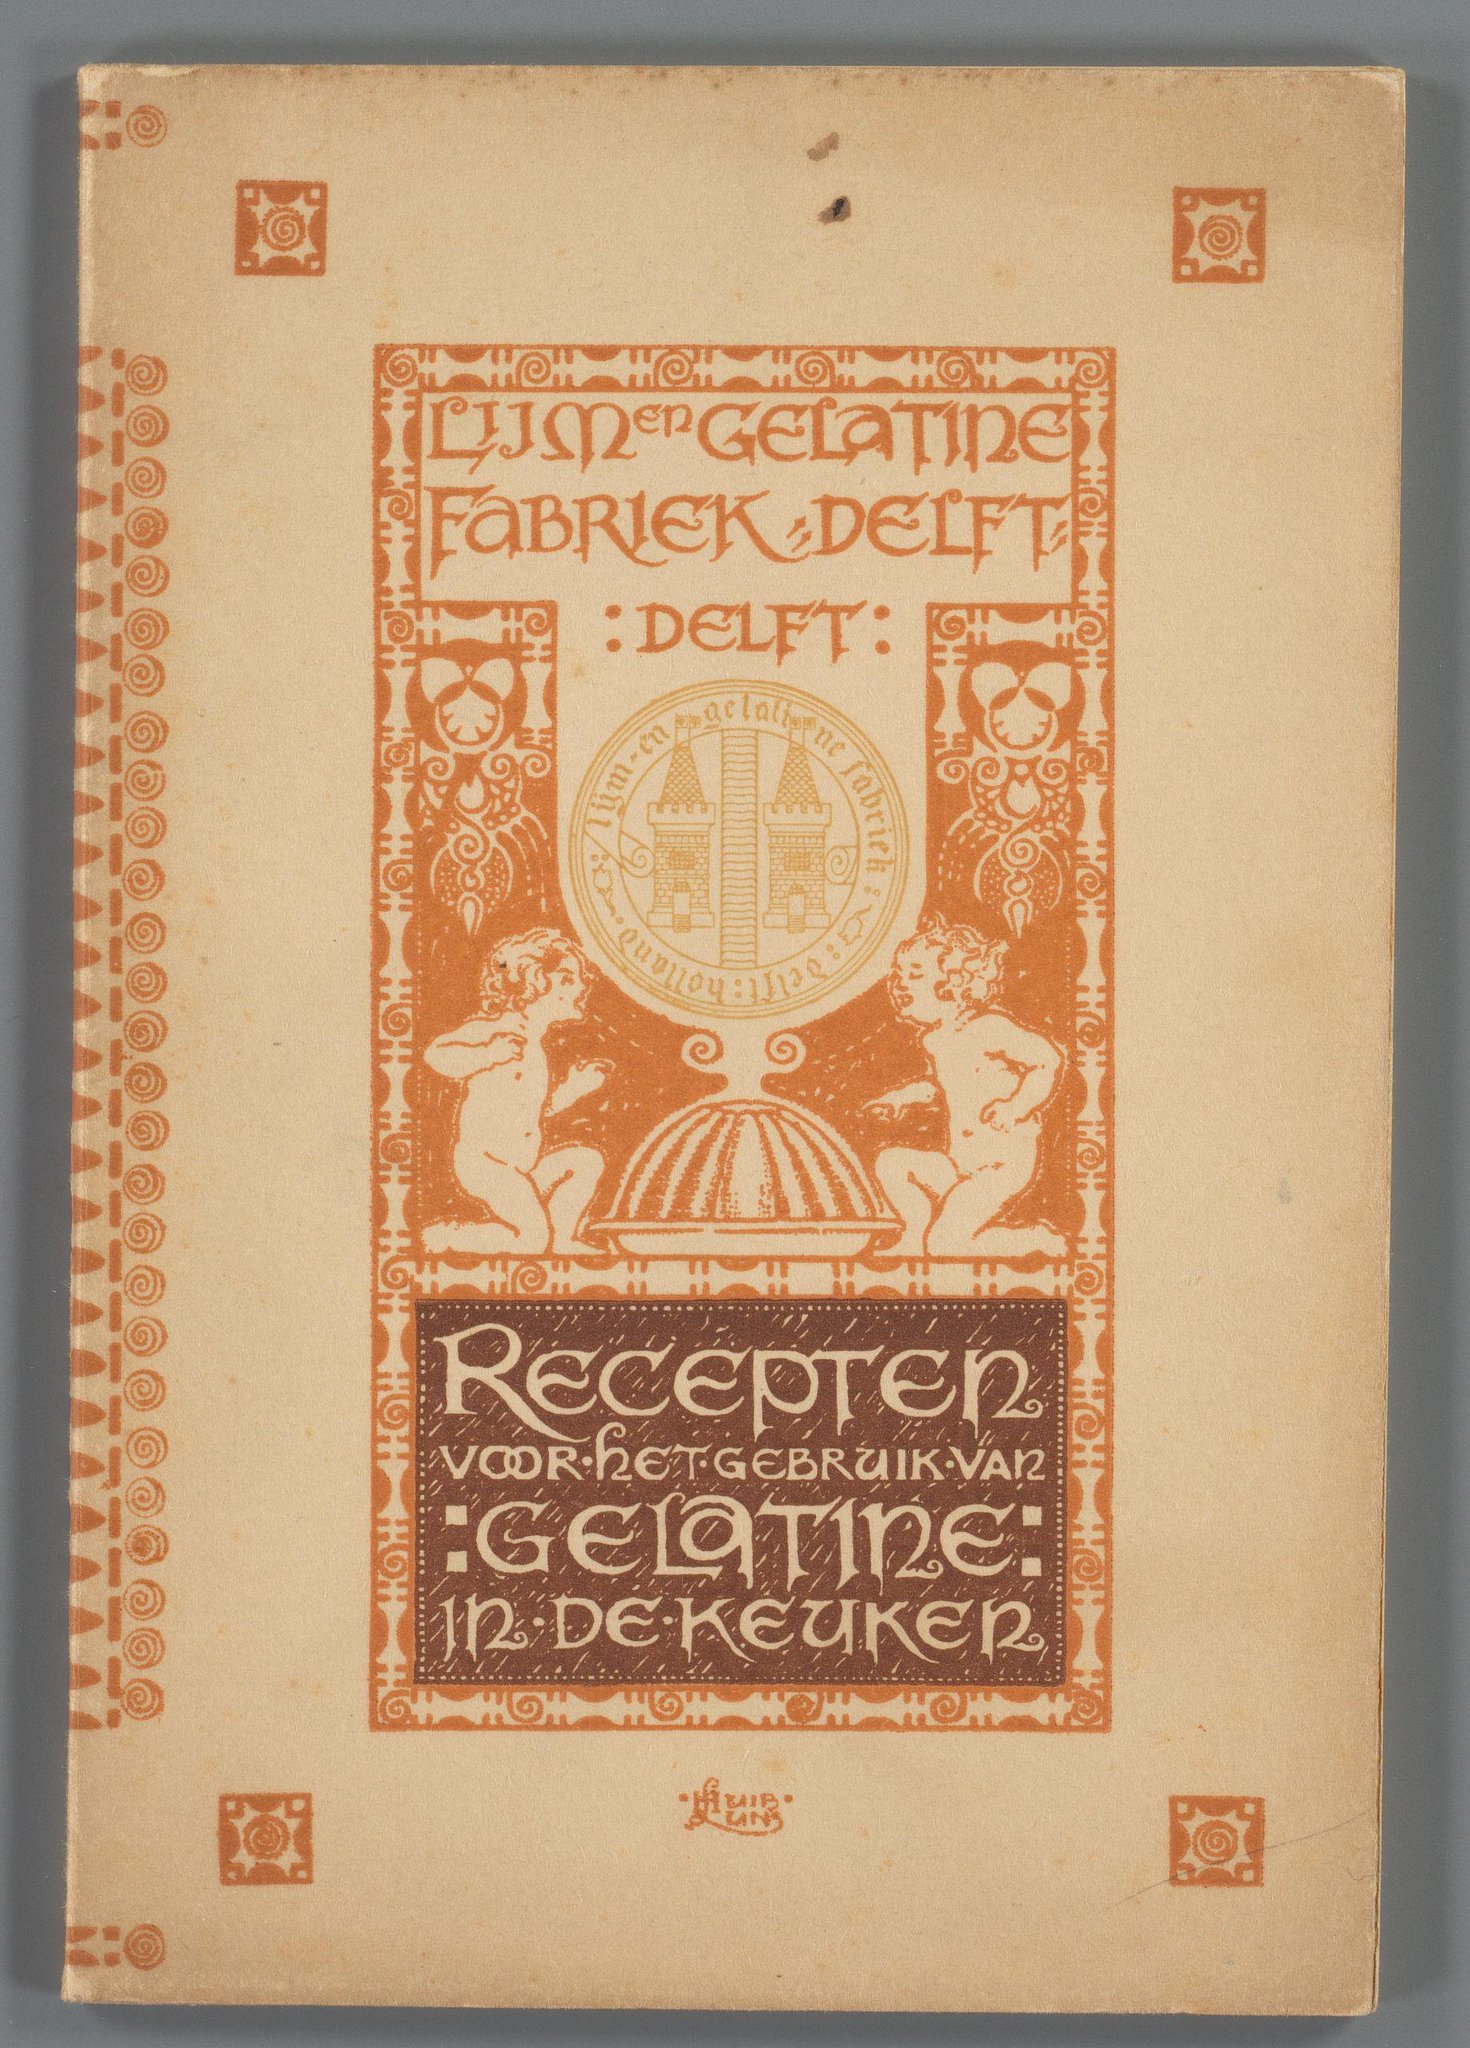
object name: book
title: Recepten voor het gebruik van gelatine in de keuken, 1918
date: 1918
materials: paper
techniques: bookbinding, printing block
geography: delft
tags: cooking food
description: Publicatie van 48 pagina's met recepten op basis van gelatine. De tekst is gedrukt binnen een kader; buiten dat kader op iedere bladzijde een andere illustratie, veelal passend bij de recepten op die bladzijde. De onderwerpen van de illustraties zijn onder andere vee, dieren, vissen, keukeninterieurs, een straatverkoper van noga, en keukengerei. Promotie uitgave van de Lijm- en Gelatinefabriek Delft.